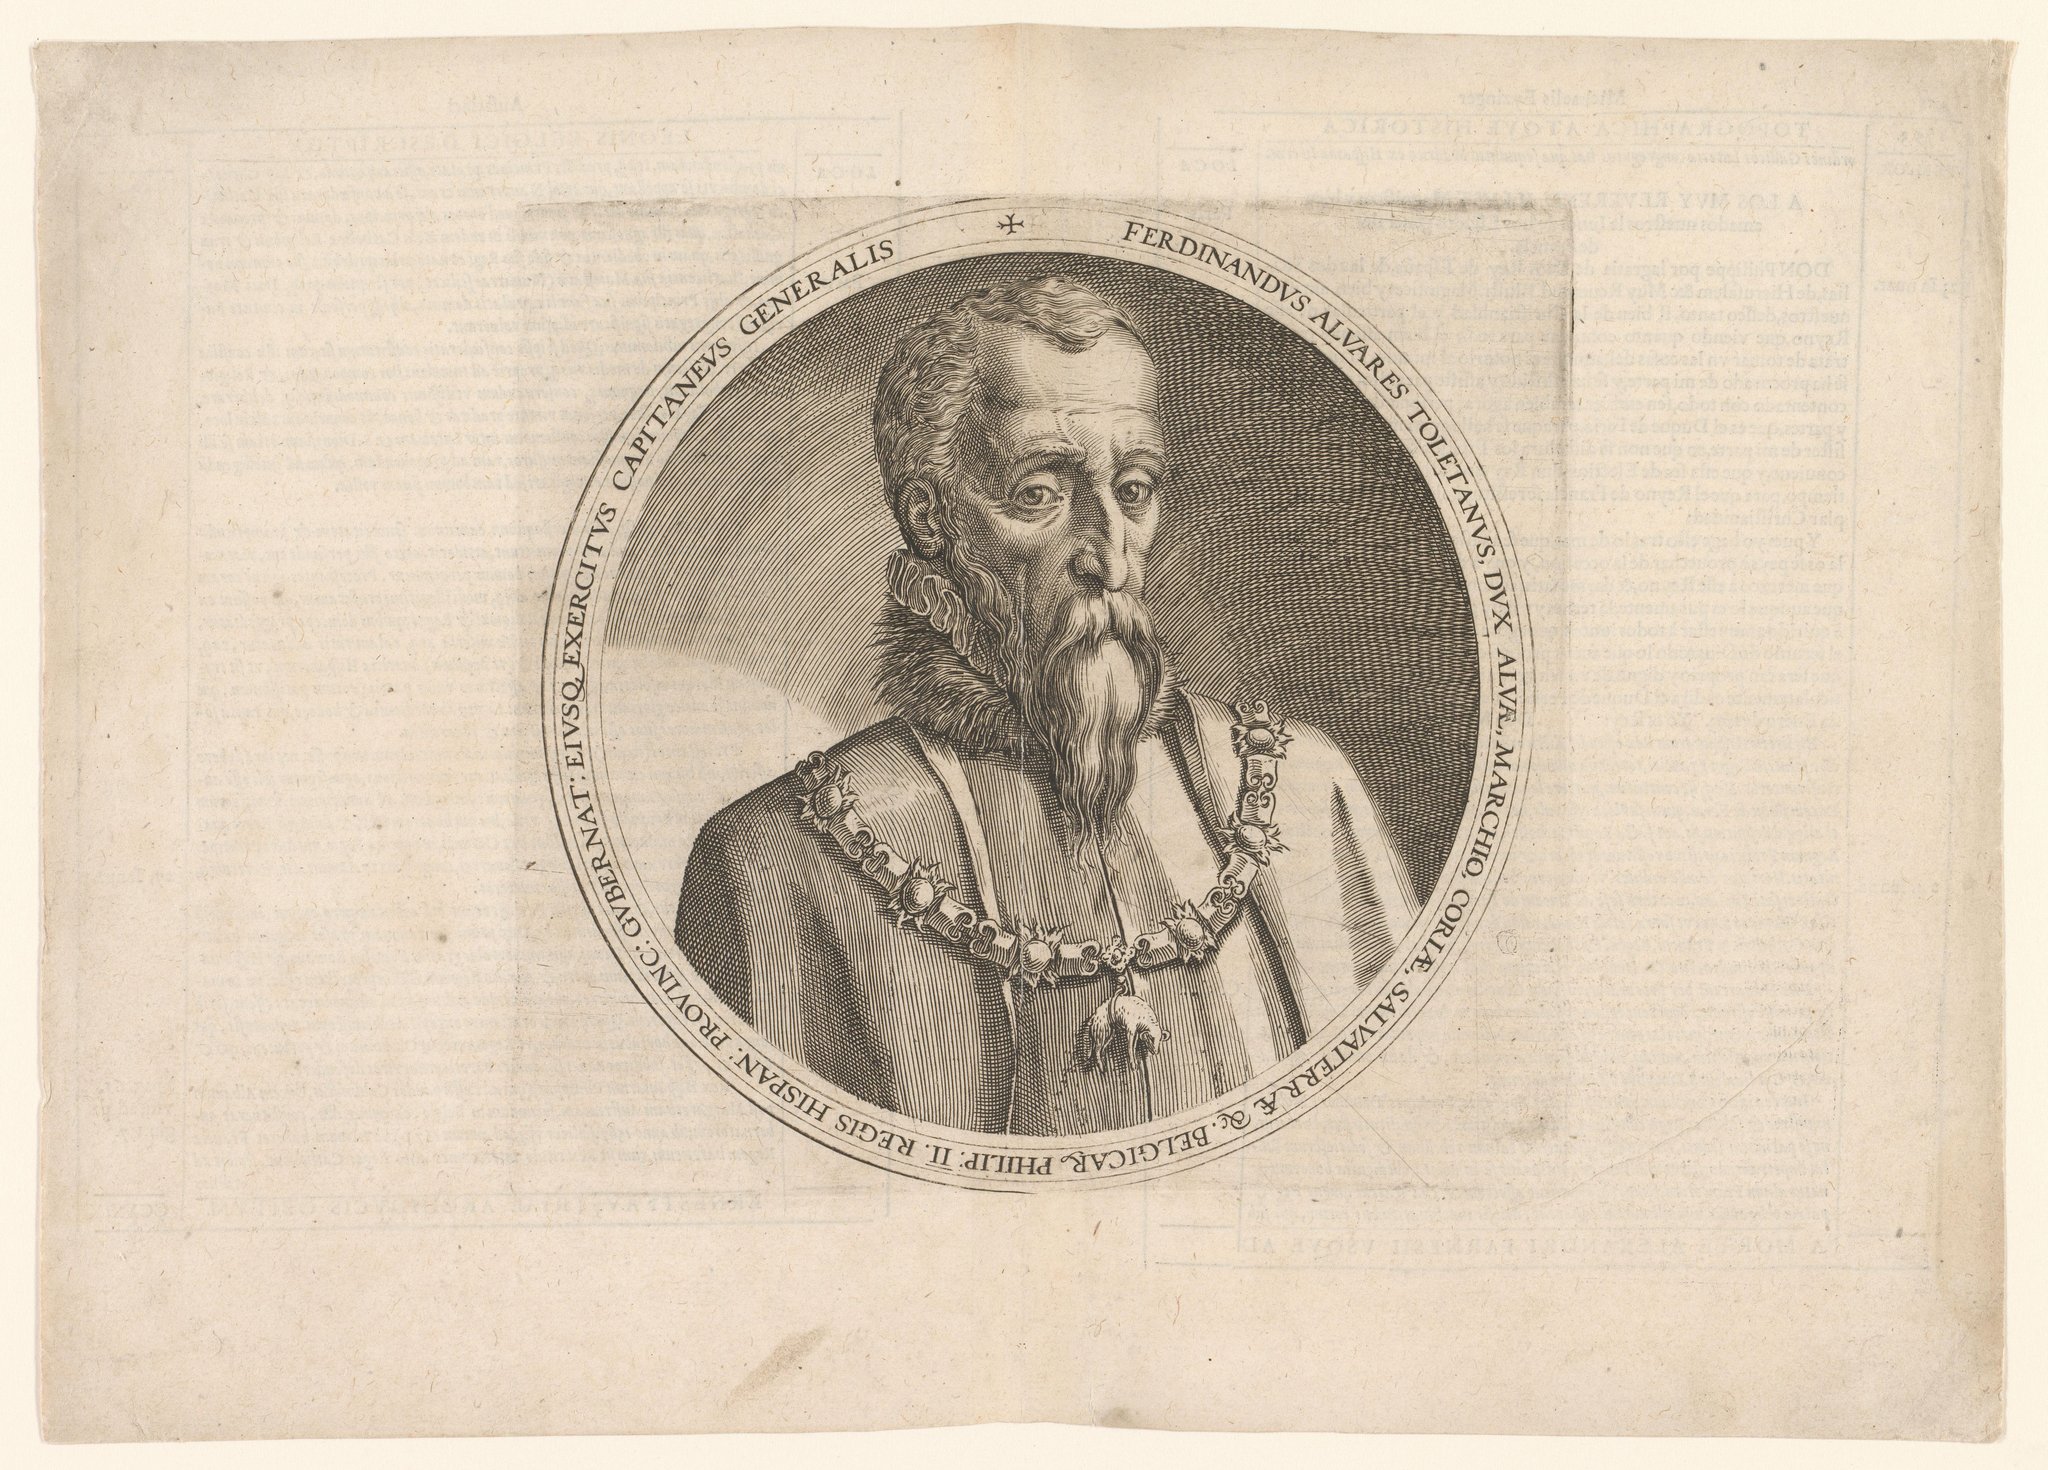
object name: print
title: Portret van de hertog van Alva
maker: frans hogenberg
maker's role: print maker, publisher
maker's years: 1538-1590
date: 1585-1587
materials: paper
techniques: engraving, letterpress printing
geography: cologne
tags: fernando álvarez de toledo (3rd duke of alba), historical persons, knighthood order of the golden fleece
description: Portret van de hertog van Alva, landvoogd der Nederlanden, buste naar rechts, ordeketting van het Gulden Vlies om de hals, in ronde lijst met randschrift in het Latijn. Bedrukt op de achterzijde met twee bladzijden (p. 468 en 467) tekst in boekdruk in het Latijn. Portret toegevoegd aan de verzameling kaarten genomen uit een latere editie van: Descrittione di tutti i Paesi Bassi van Lodovico Guicciardini.